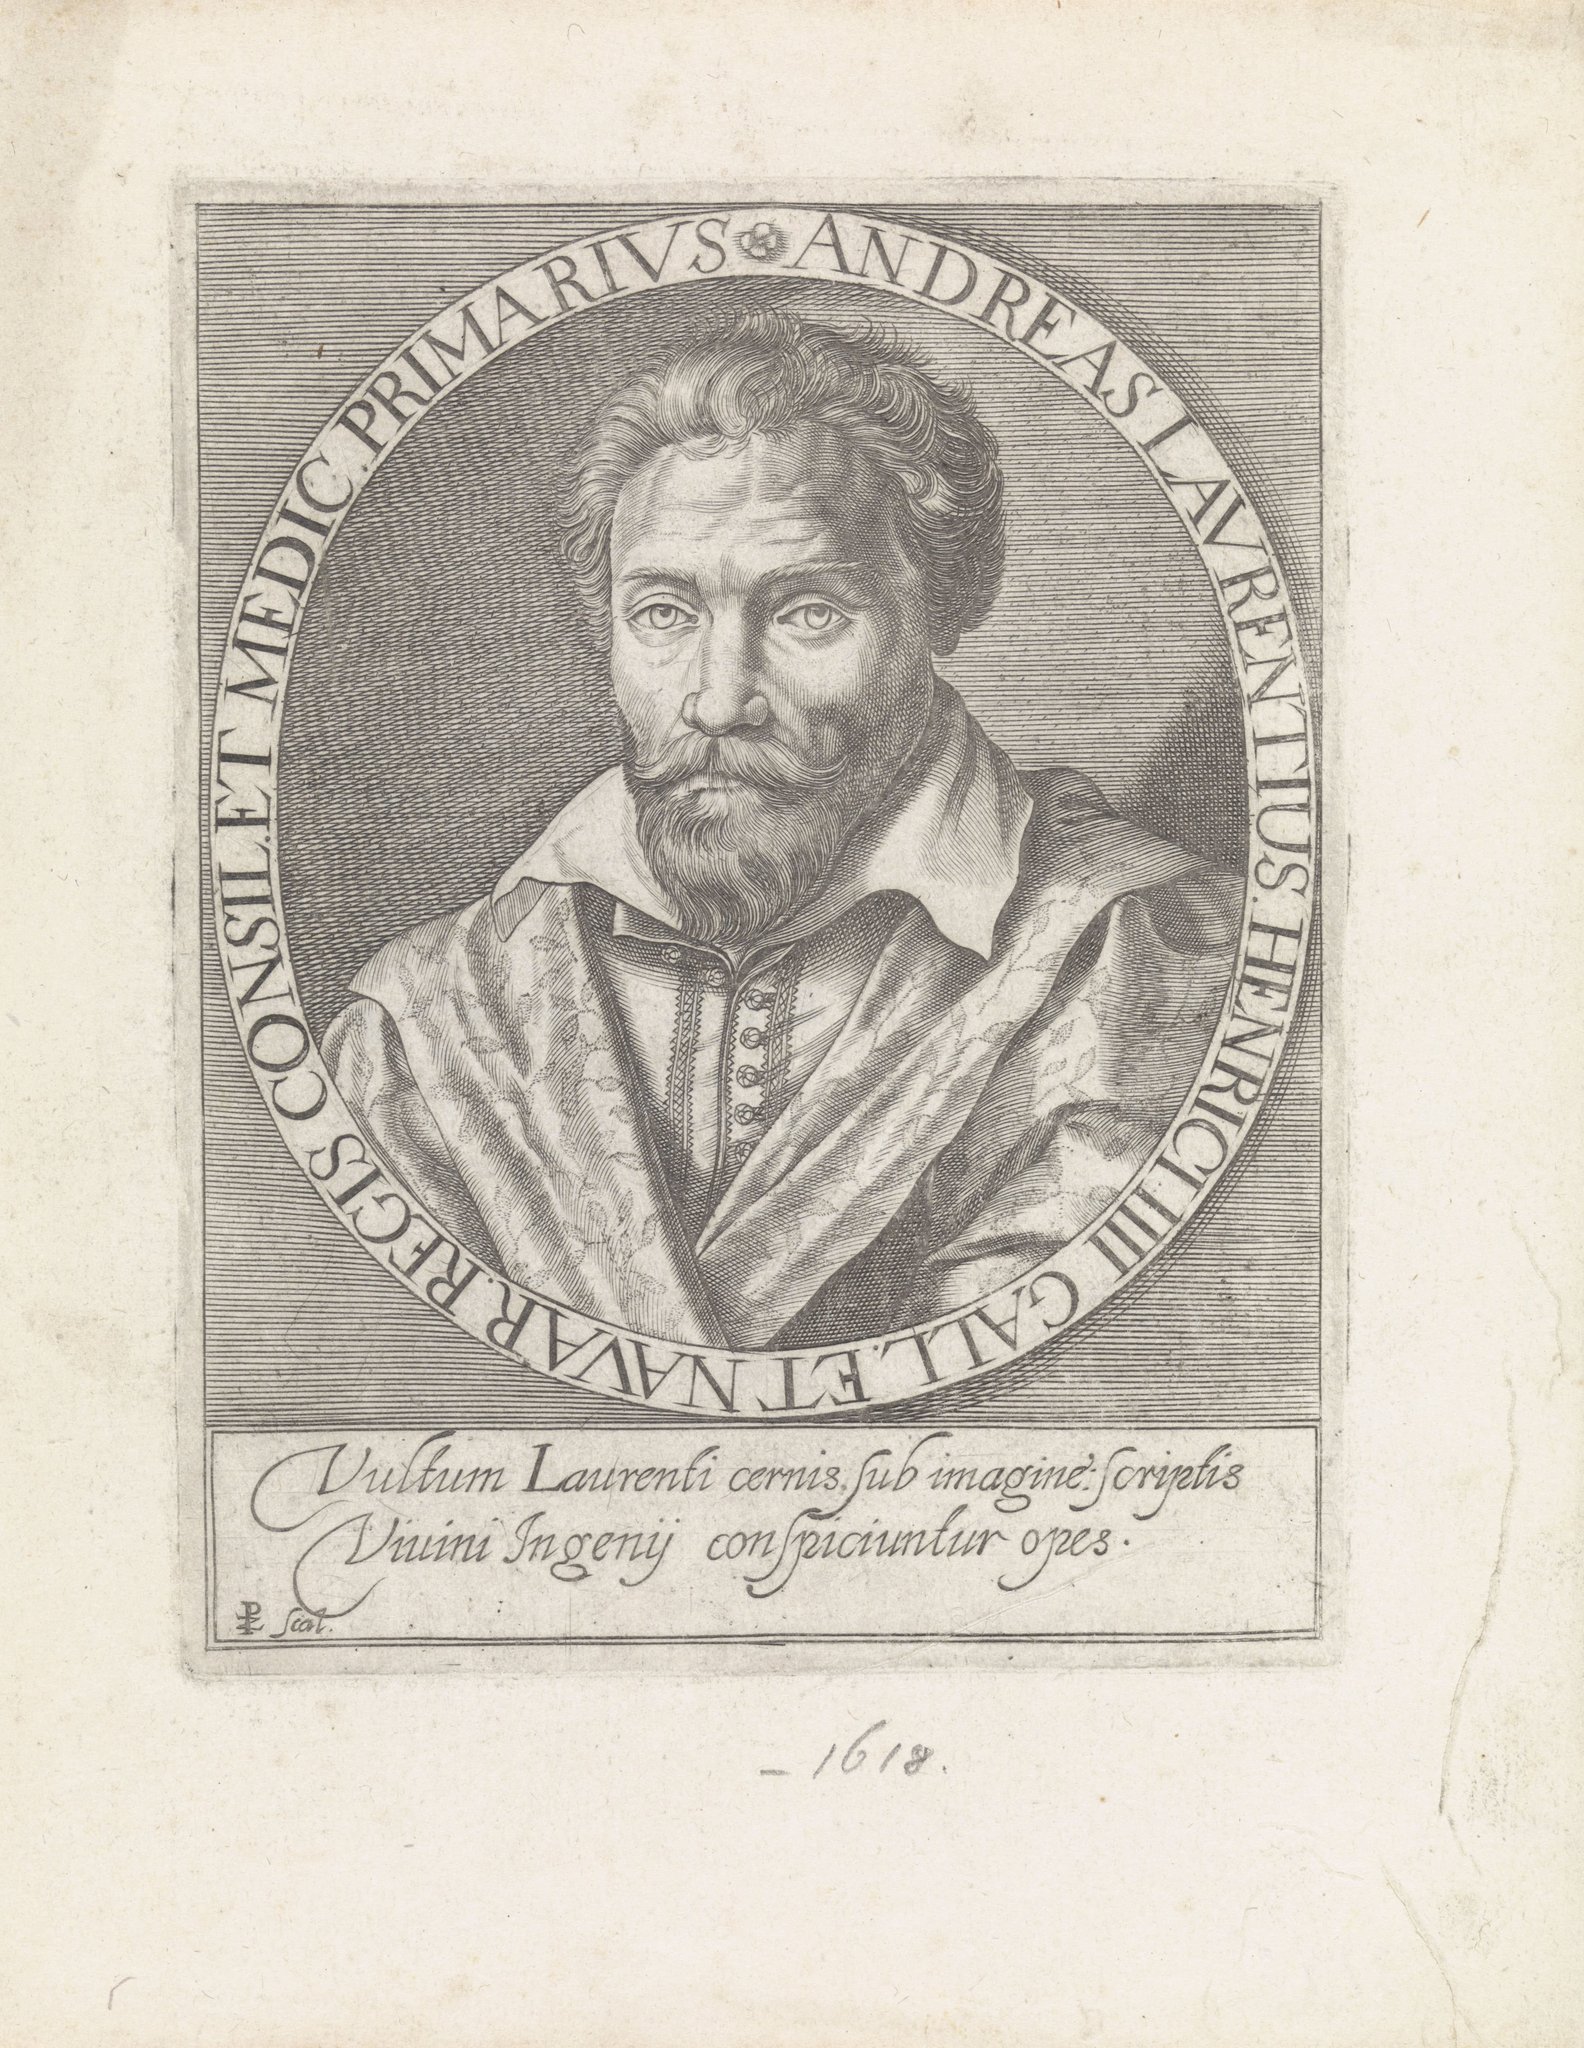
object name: book illustration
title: Portret van Andre du Laurens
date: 1628-1645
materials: paper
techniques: engraving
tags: andré du laurens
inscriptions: collector's mark: Lugt 2233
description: Prent gebruikt in een van de edities van Jean-Jacques Boissard. Boissard, Jean-Jacques. Bibliotheca sive Thesaurus Virtutis et Gloriae: In quo continentus Illvstrivm Ervditione & doctrina Virorum Effigies & Vitae (...). Frankfurt, [1628]. Zie Hollstein Dutch, deel LVIII, p. 86-87.